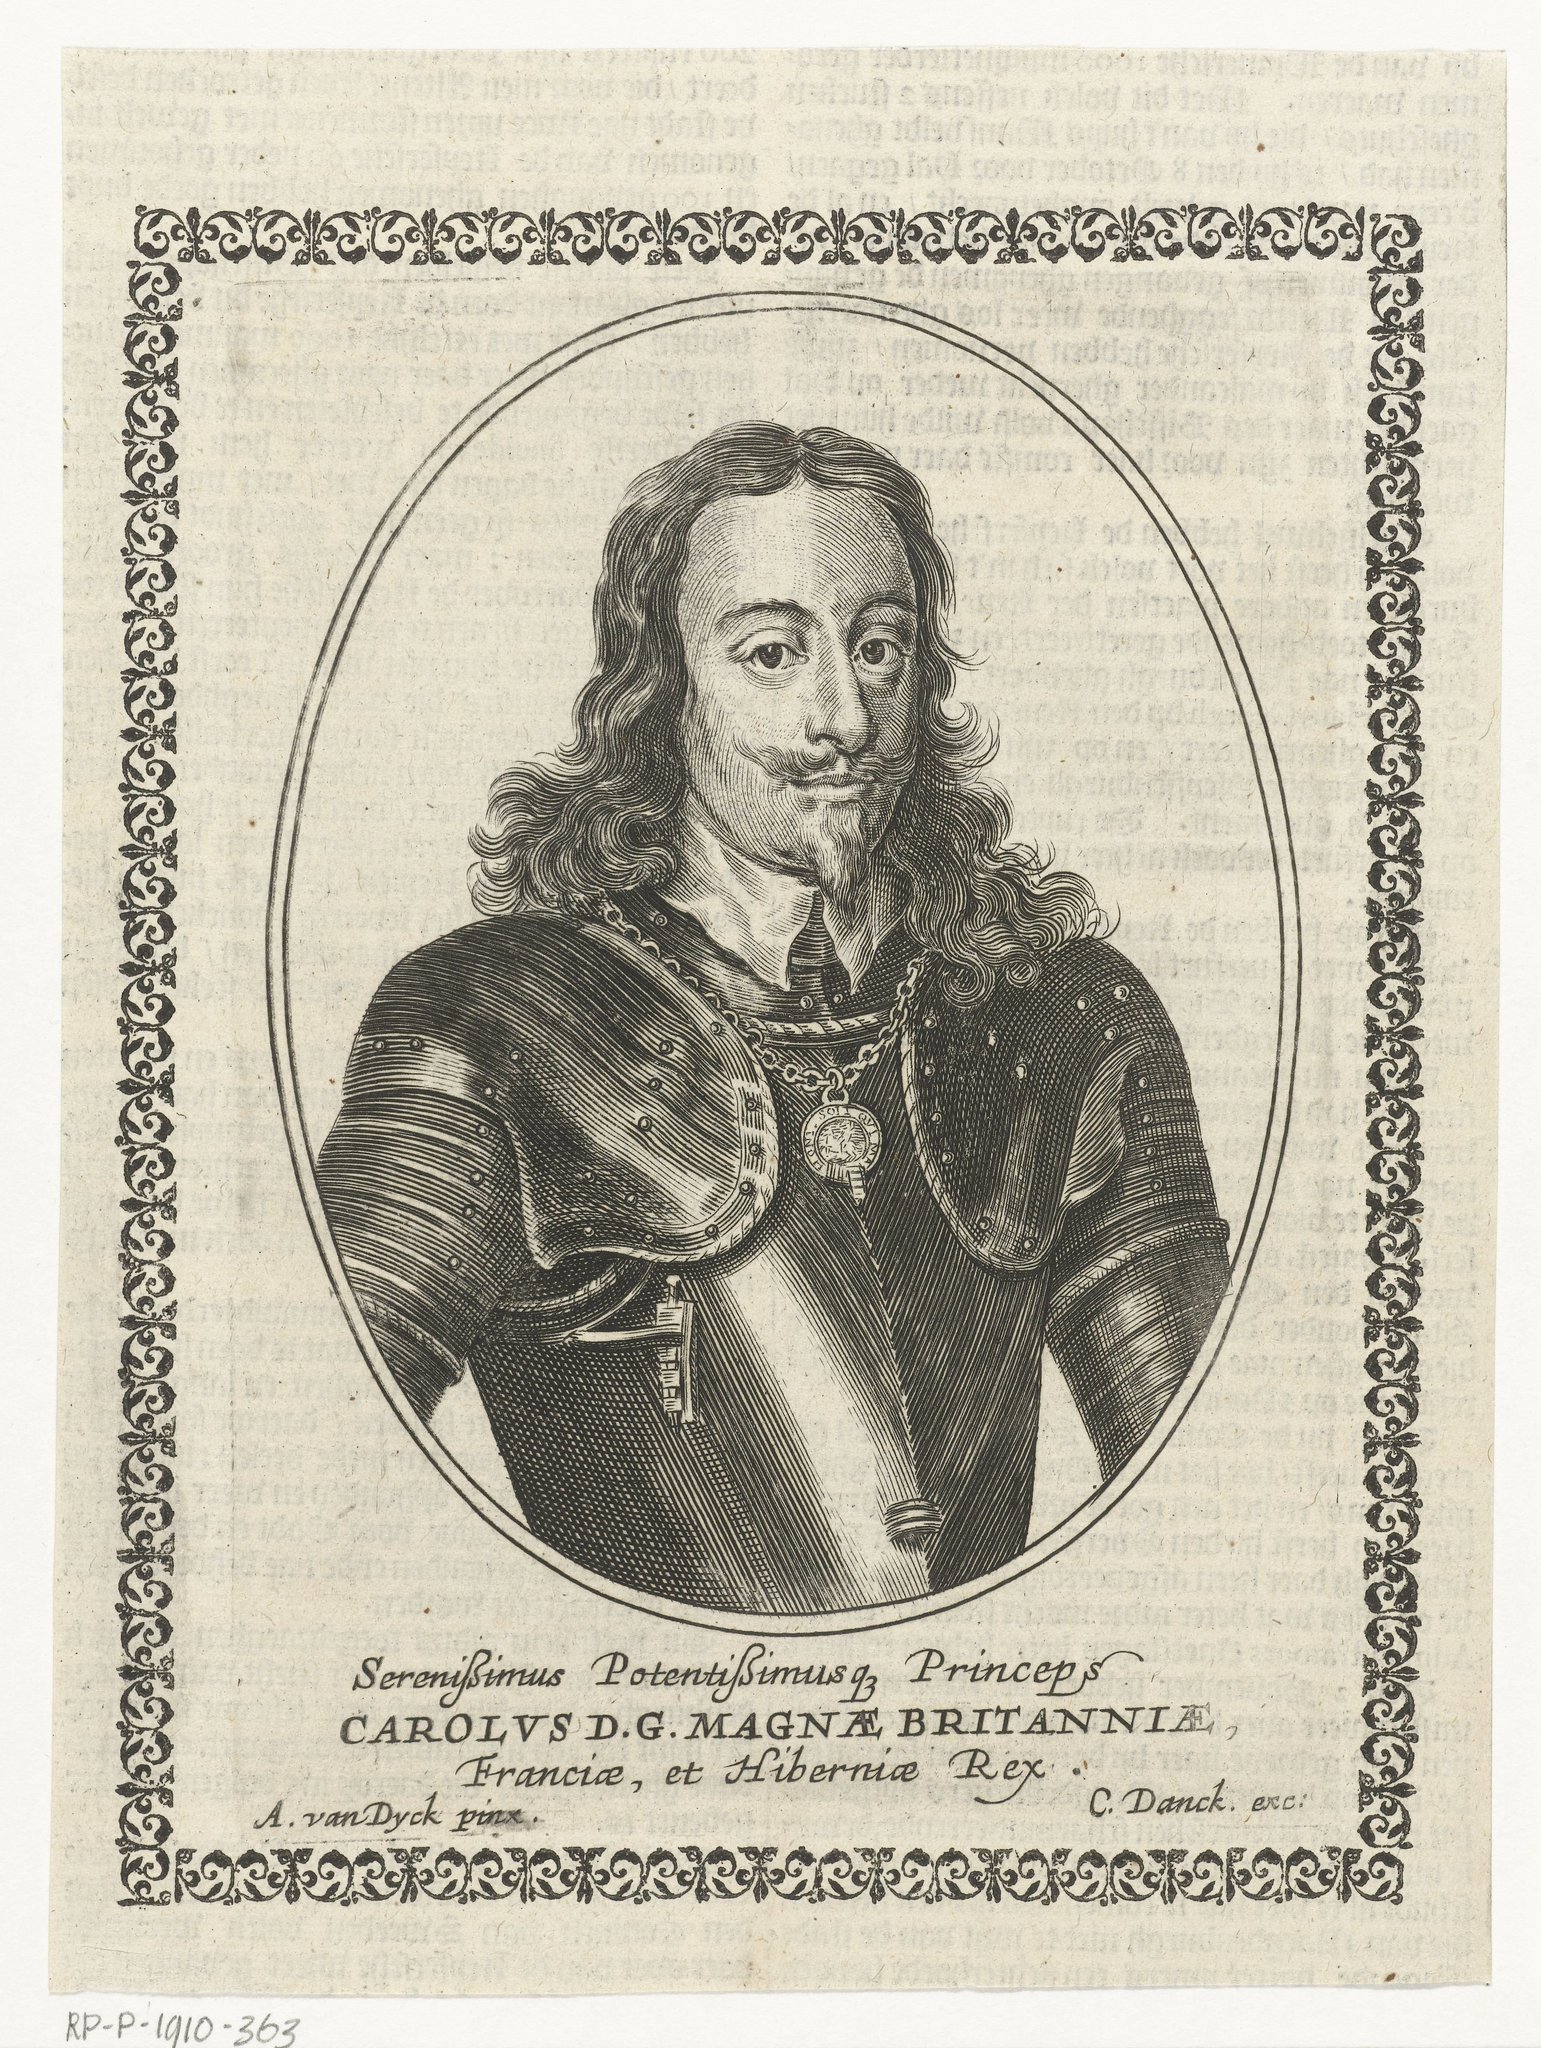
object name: book illustration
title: Serenißimus Potentißimus Princeps Carolvs D.G. Magnae Britanniae, Franciae et Hiberniae Rex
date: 1613-1656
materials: paper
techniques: engraving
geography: netherlands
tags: london, karel i (koning van engeland)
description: Prent naar schilderij van Anthony van Dyck. Prent gebruikt als boekillustratie in onbekende uitgave. Niet beschreven bij Hollstein.